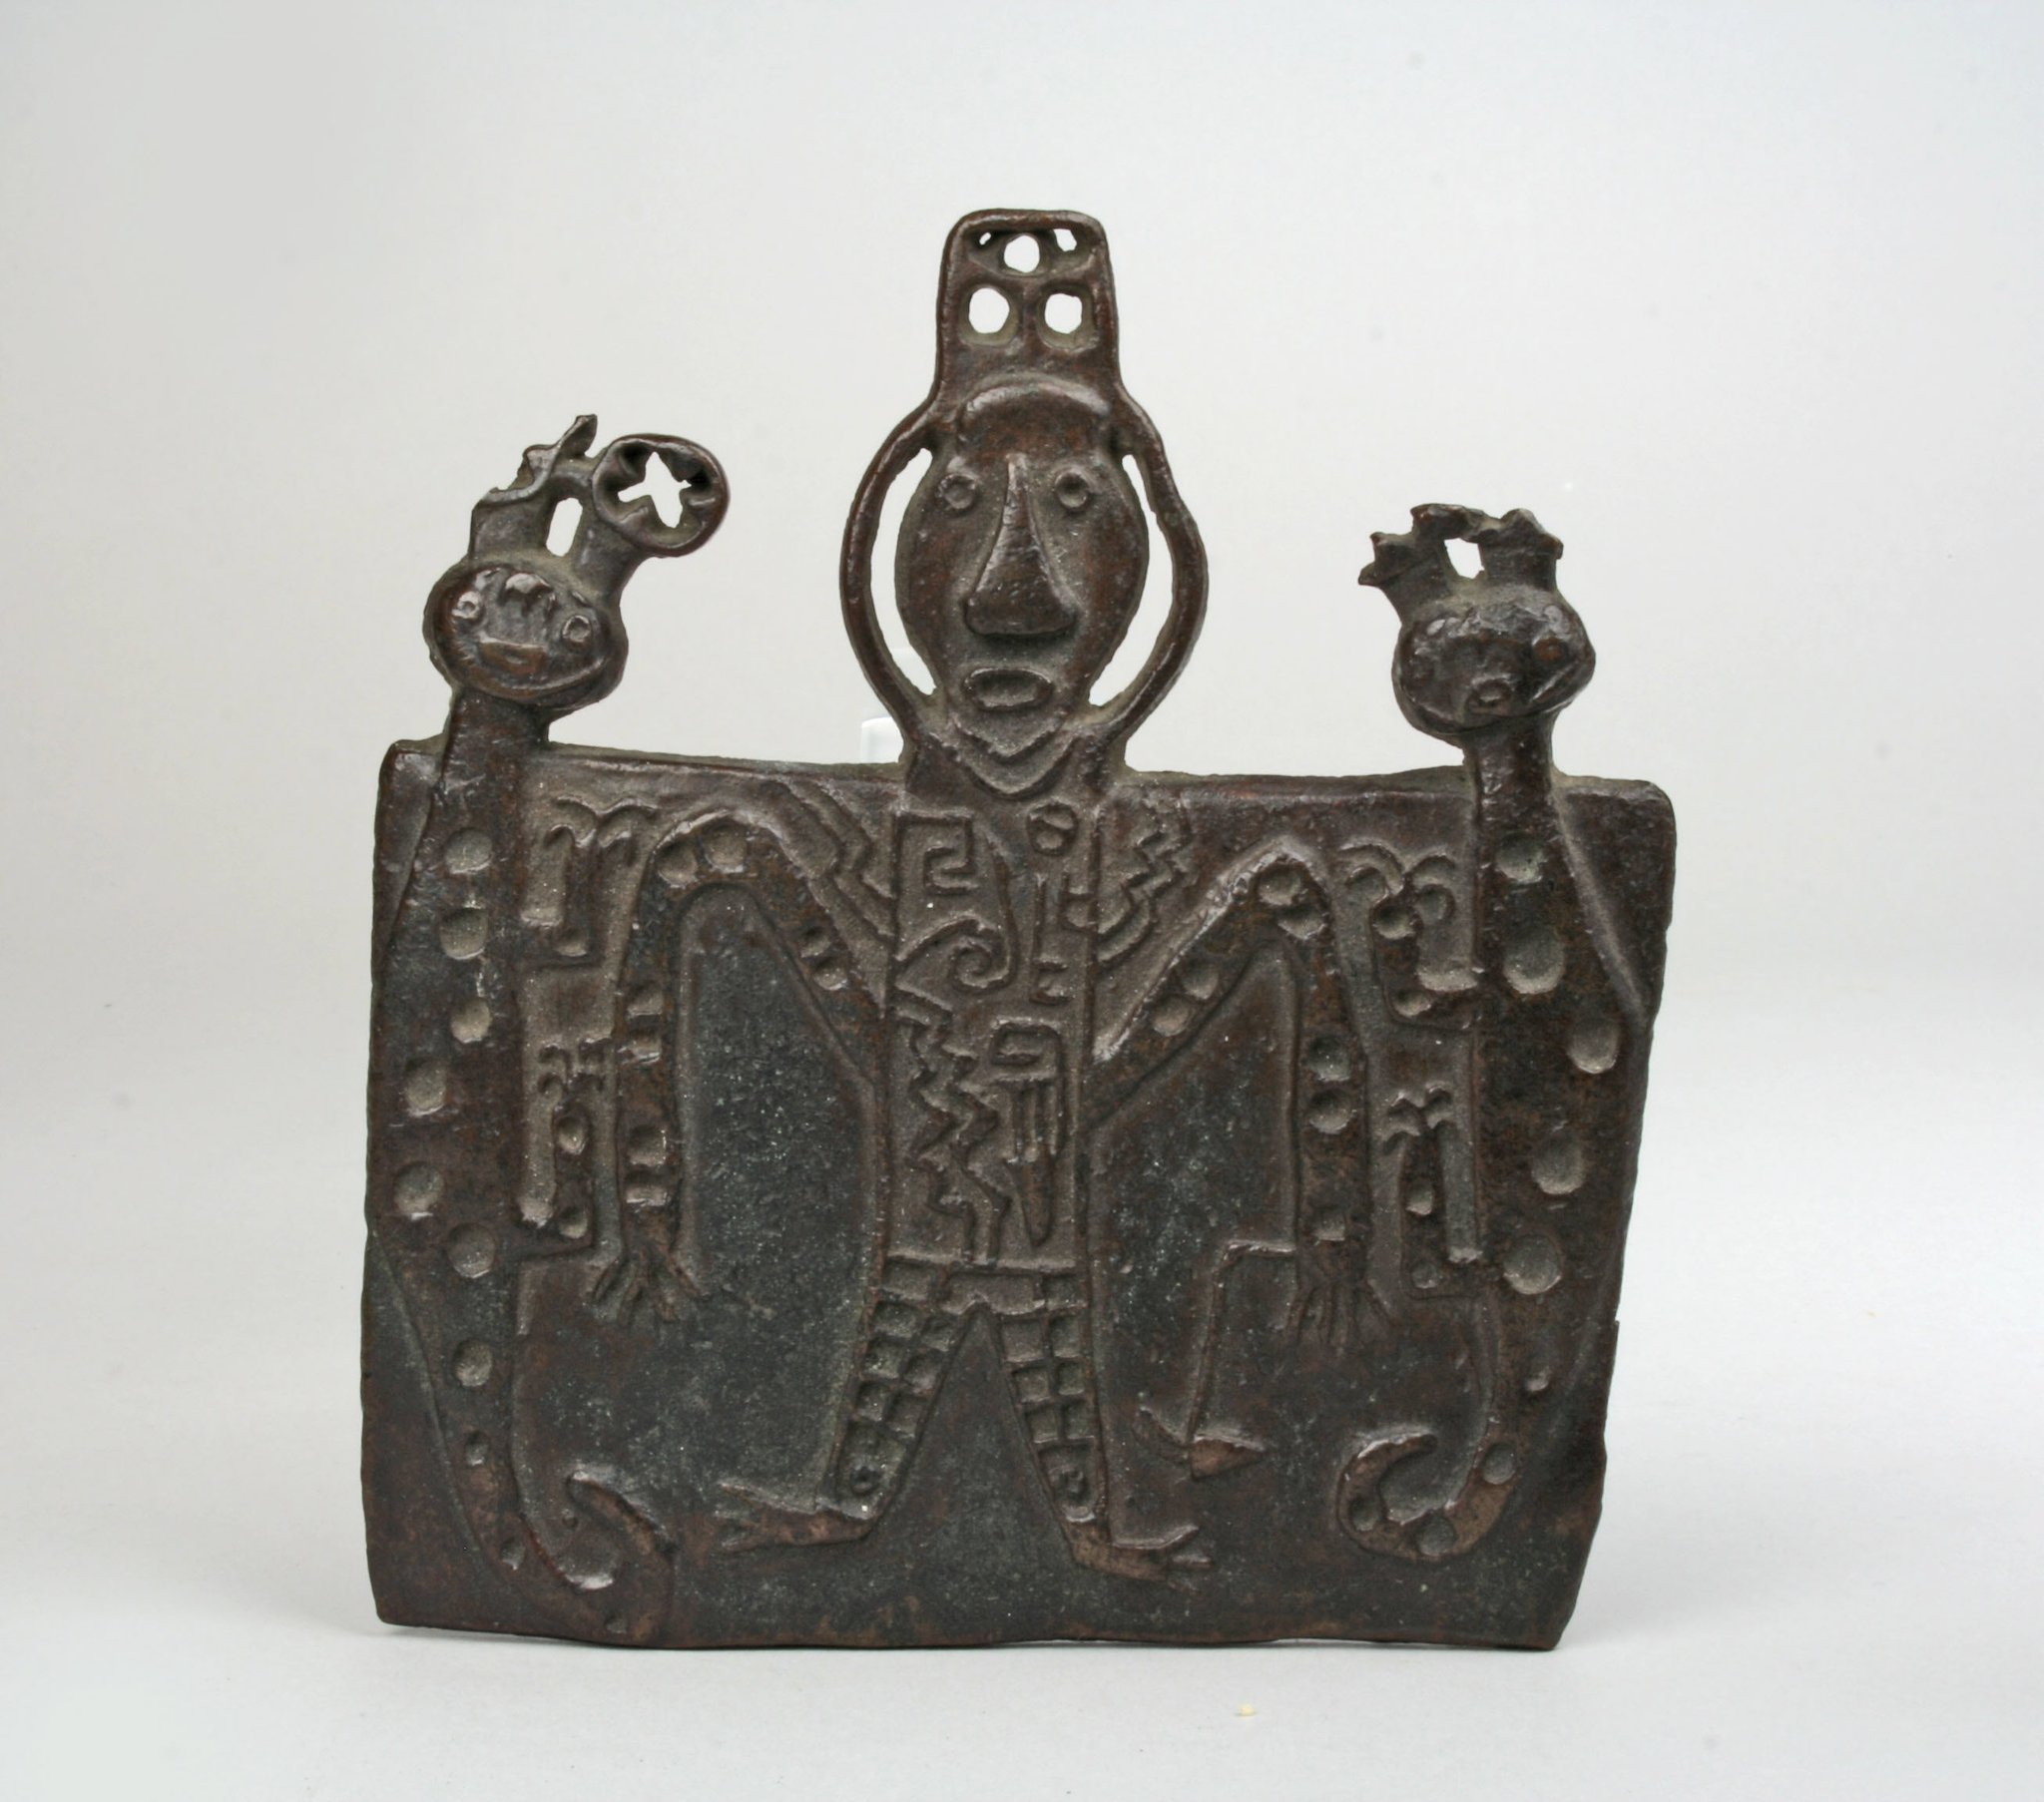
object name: plaque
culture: aguada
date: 450-900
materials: copper alloy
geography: argentina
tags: human figures